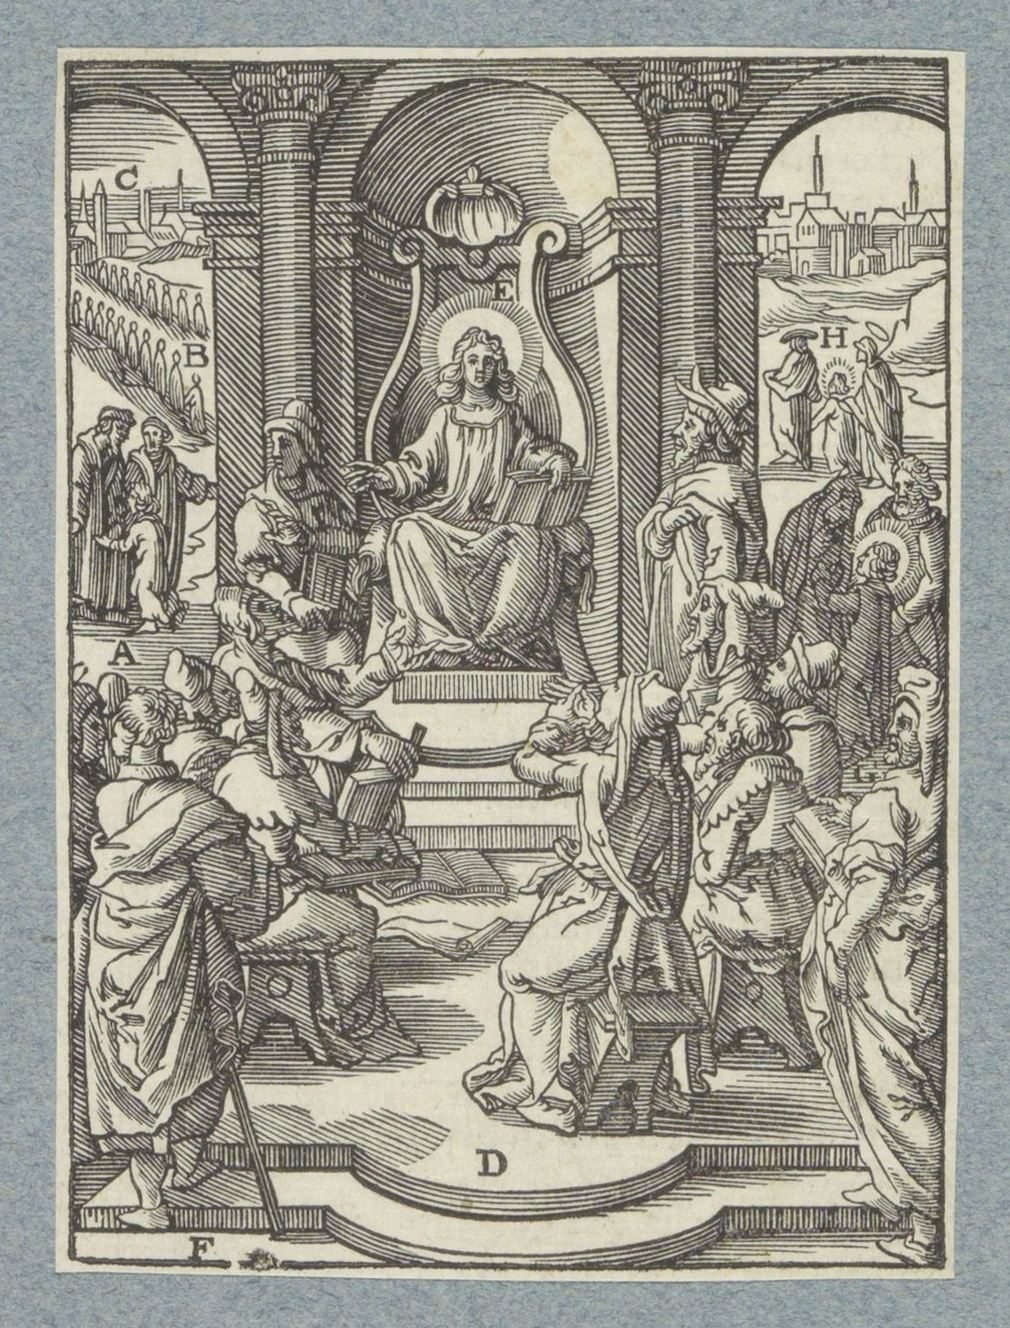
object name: book illustration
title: Christus als twaalfjarige in de tempel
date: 1629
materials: paper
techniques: letterpress printing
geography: amsterdam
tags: christ's dispute with the doctors in the temple; he counts his arguments on his fingers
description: De prent is afkomstig uit een van de uitgaven van P.J. Paets uit Amsterdam. De prent wordt voor het eerst gebruikt in: Der Zielen Lust-hof. Leuven, I.Jacbosz voor P.J. Paets [= Amsterdam, P.J. Paets], 1629. De voorstelling is gekopieerd naar een prent van Hieronymus Wierix voor: Nadal, Jerónimo. Evangelicae Historiae Imagines. Antwerpen, M. Nutius, 1593.